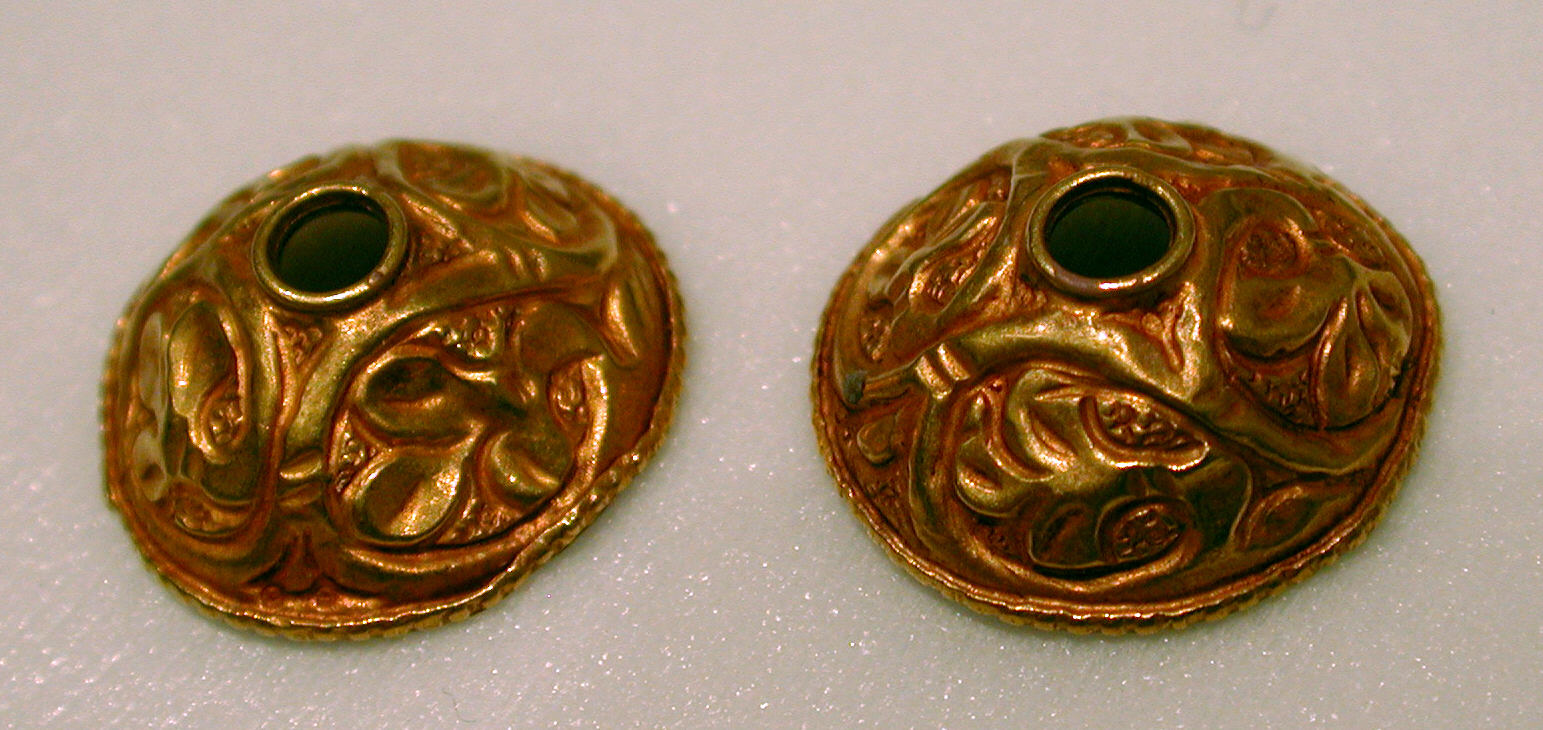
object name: element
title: Elements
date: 1001-1200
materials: gold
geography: iran